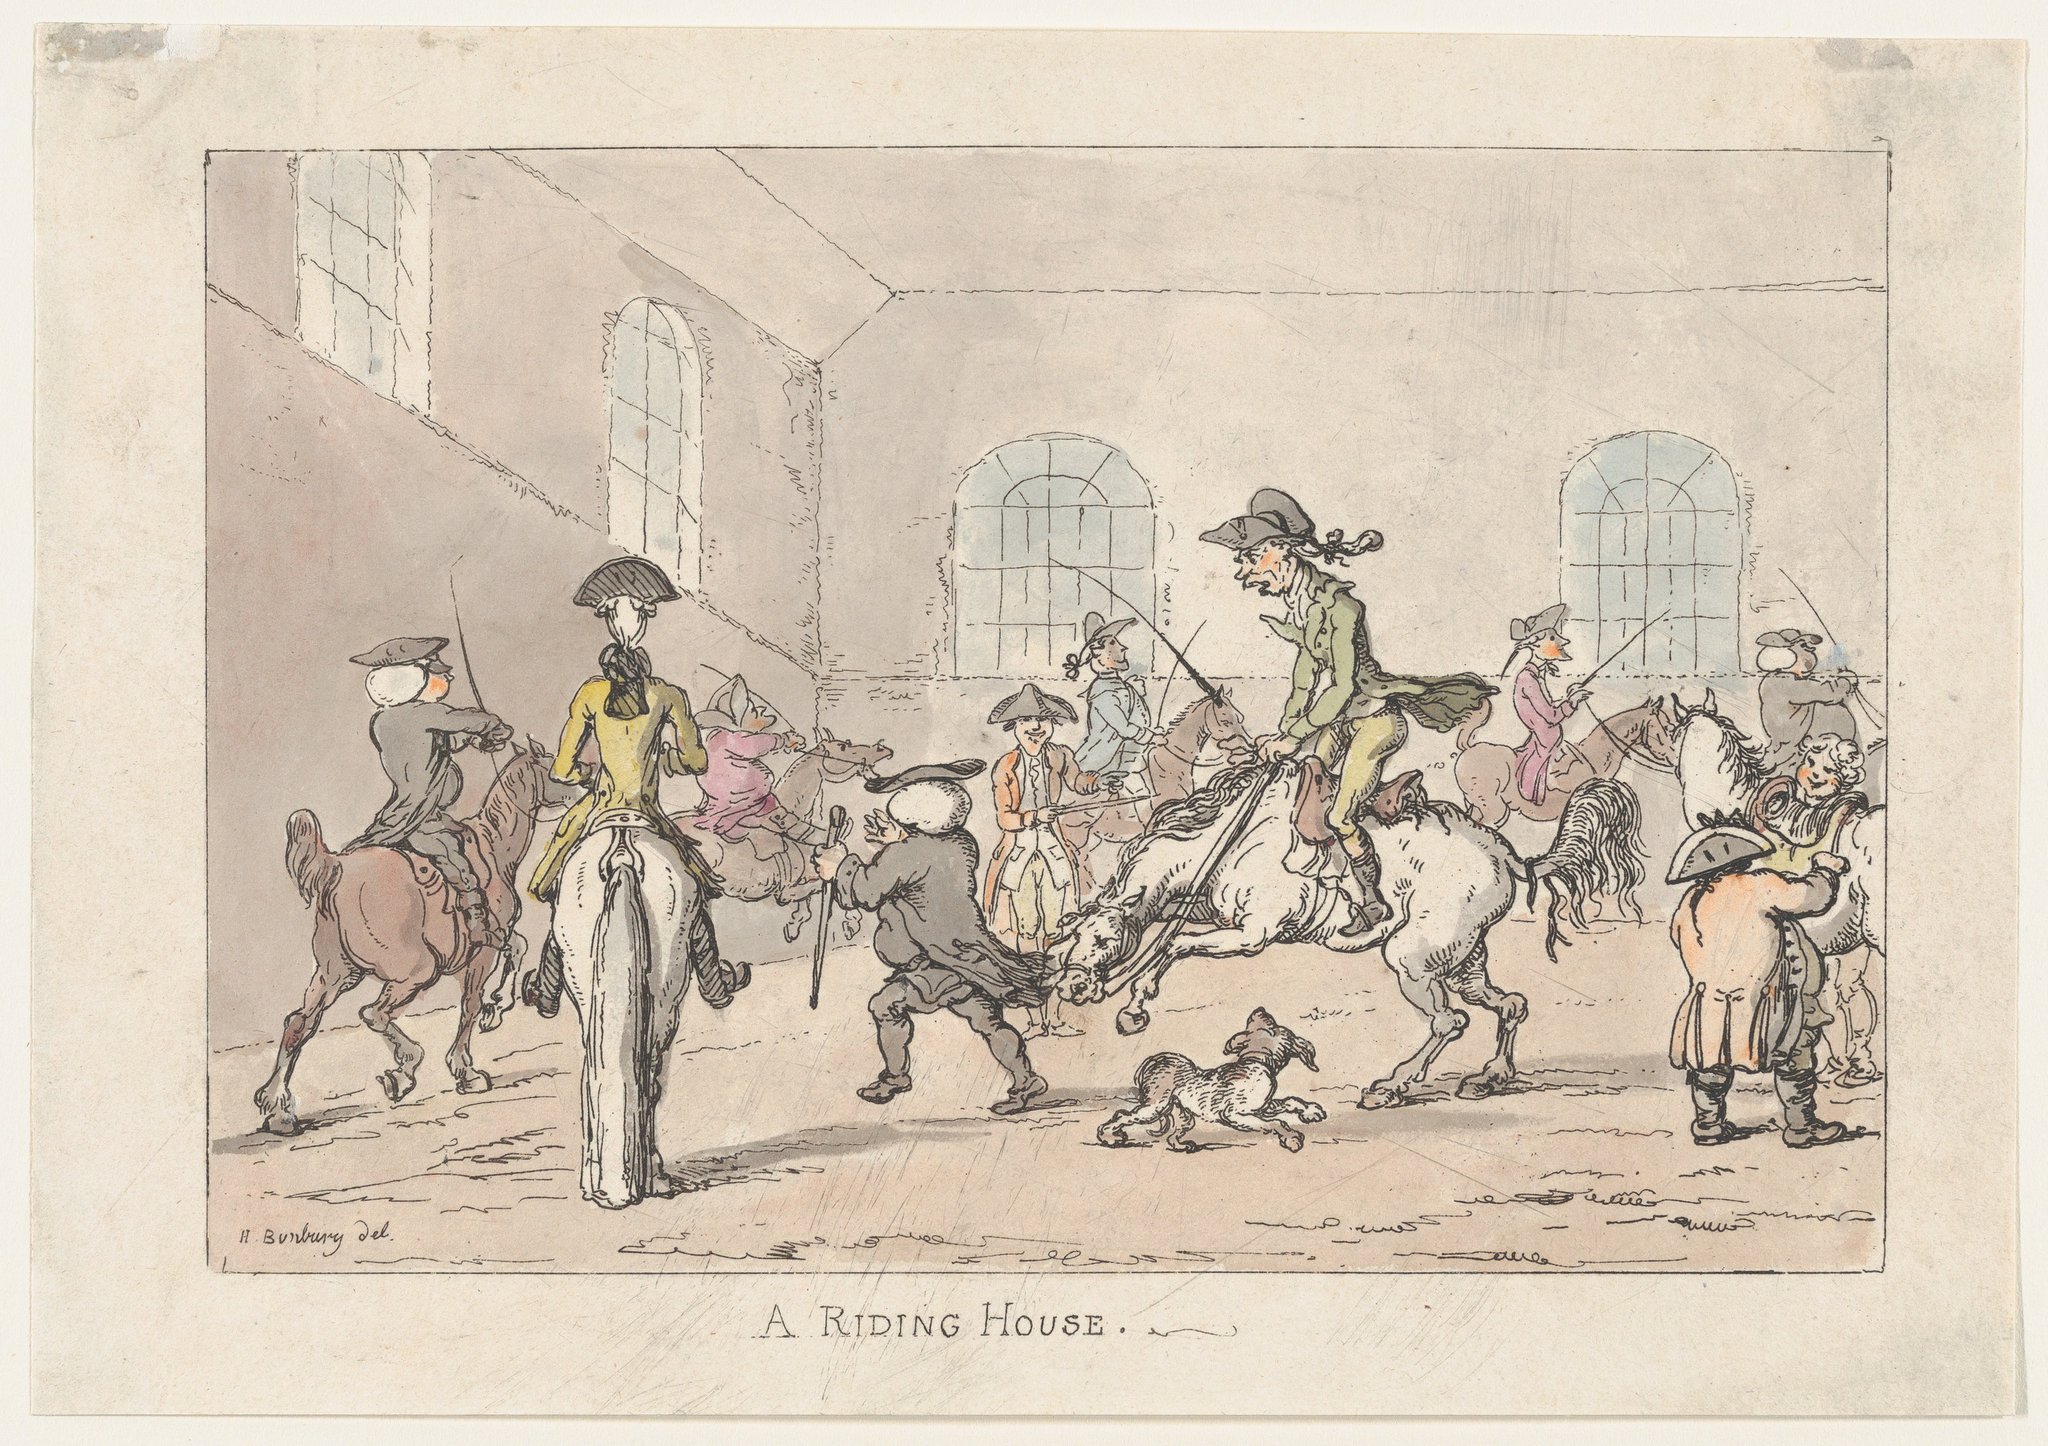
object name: print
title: A Riding House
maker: thomas rowlandson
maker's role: artist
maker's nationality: british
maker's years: 1757-1827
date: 1799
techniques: etching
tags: satire,men,dogs,horses